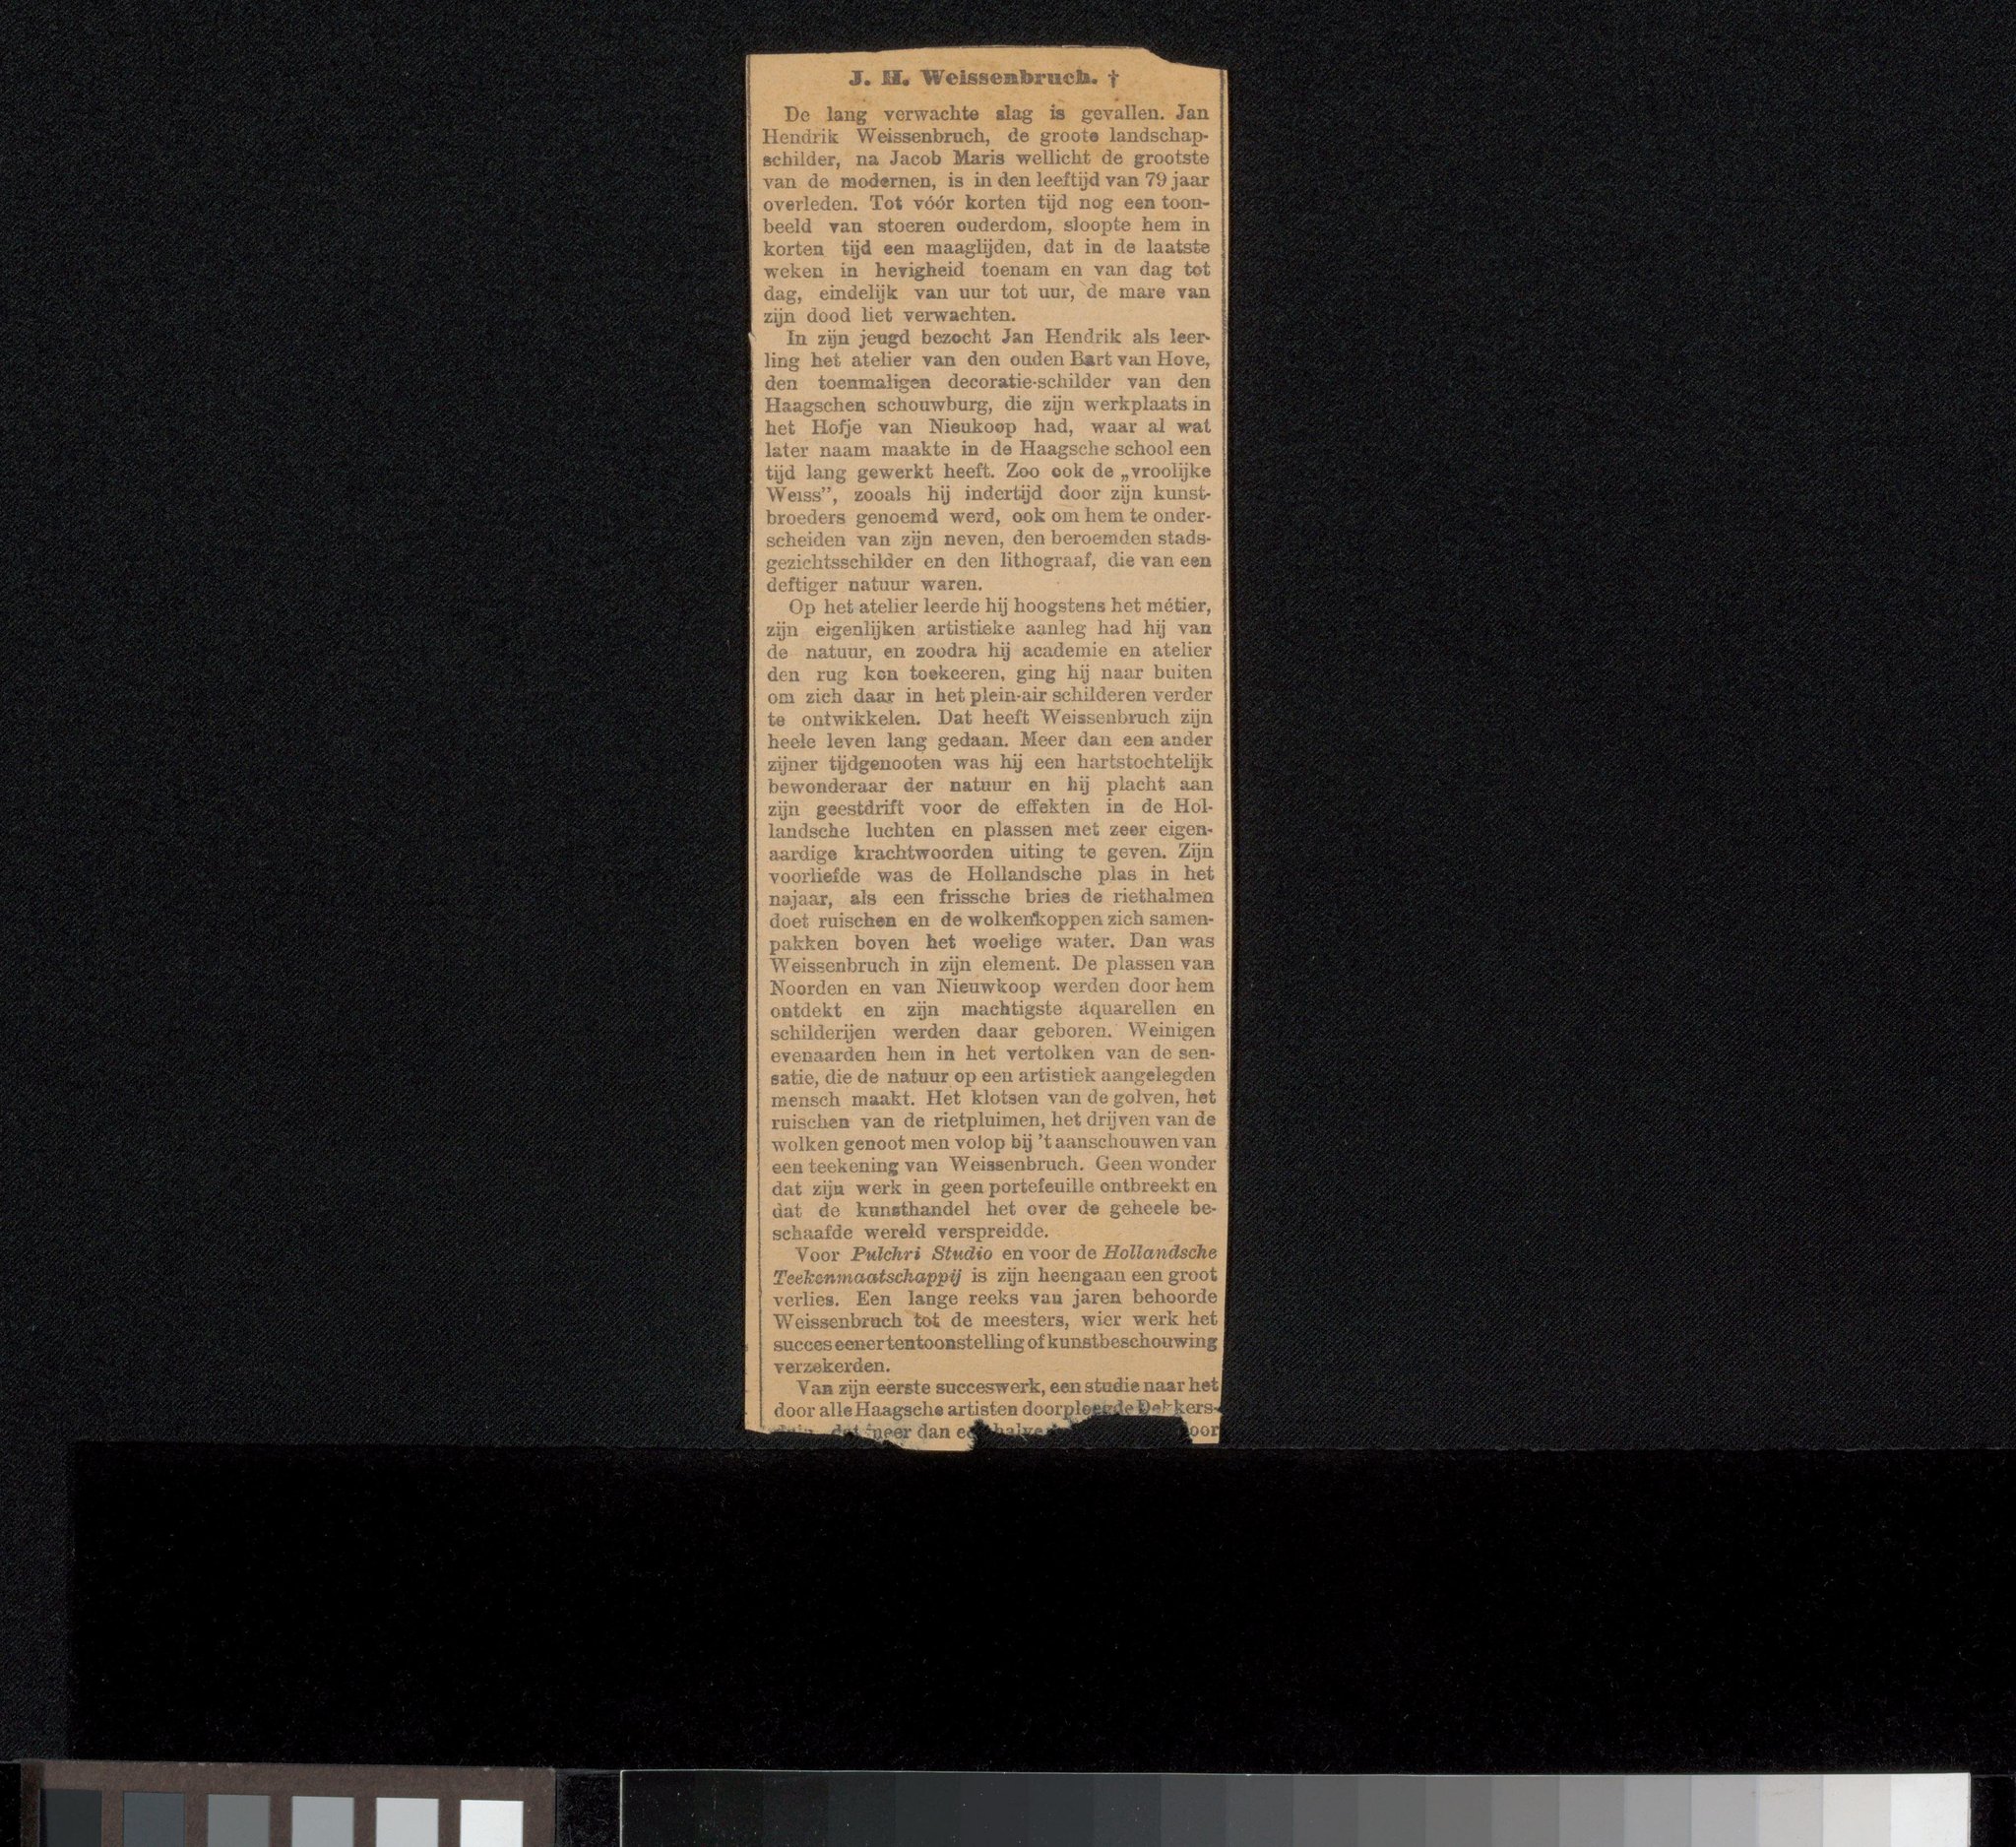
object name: newspaper clipping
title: Krantenknipsel uit archief Philip Zilcken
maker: Anonymous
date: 1903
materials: paper, ink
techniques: printing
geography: the hague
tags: johan hendrik weissenbruch, painter, draughtsman, philip zilcken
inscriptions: collector's mark: ‘RPK’